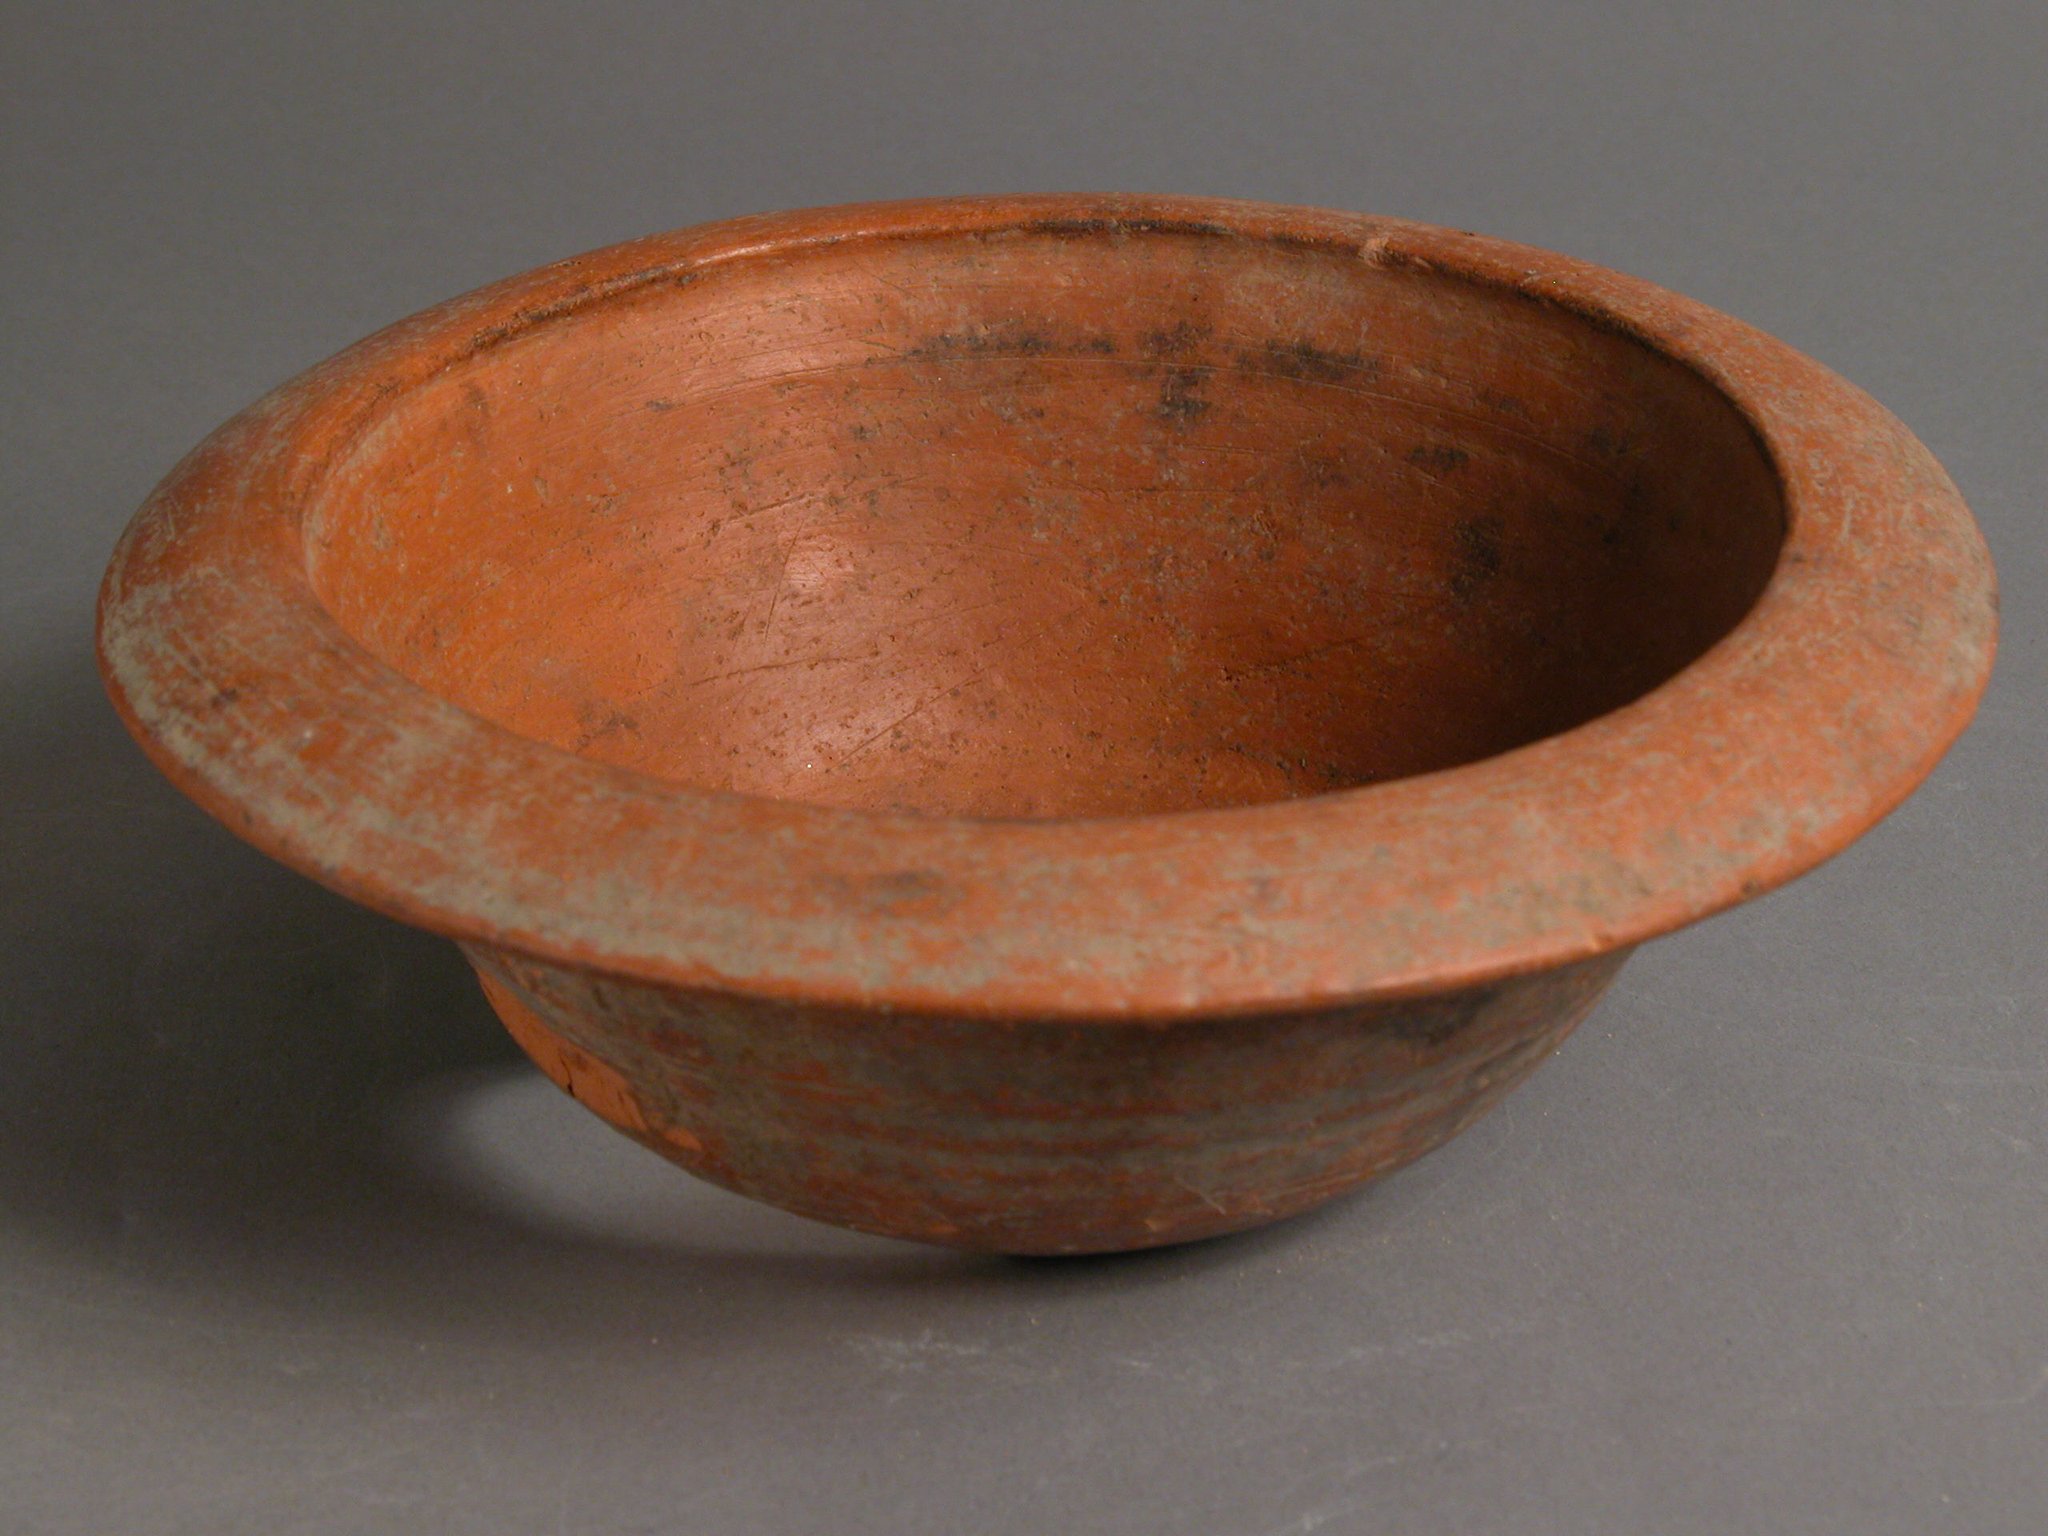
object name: bowl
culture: coptic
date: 301-700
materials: earthenware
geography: egypt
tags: bowls